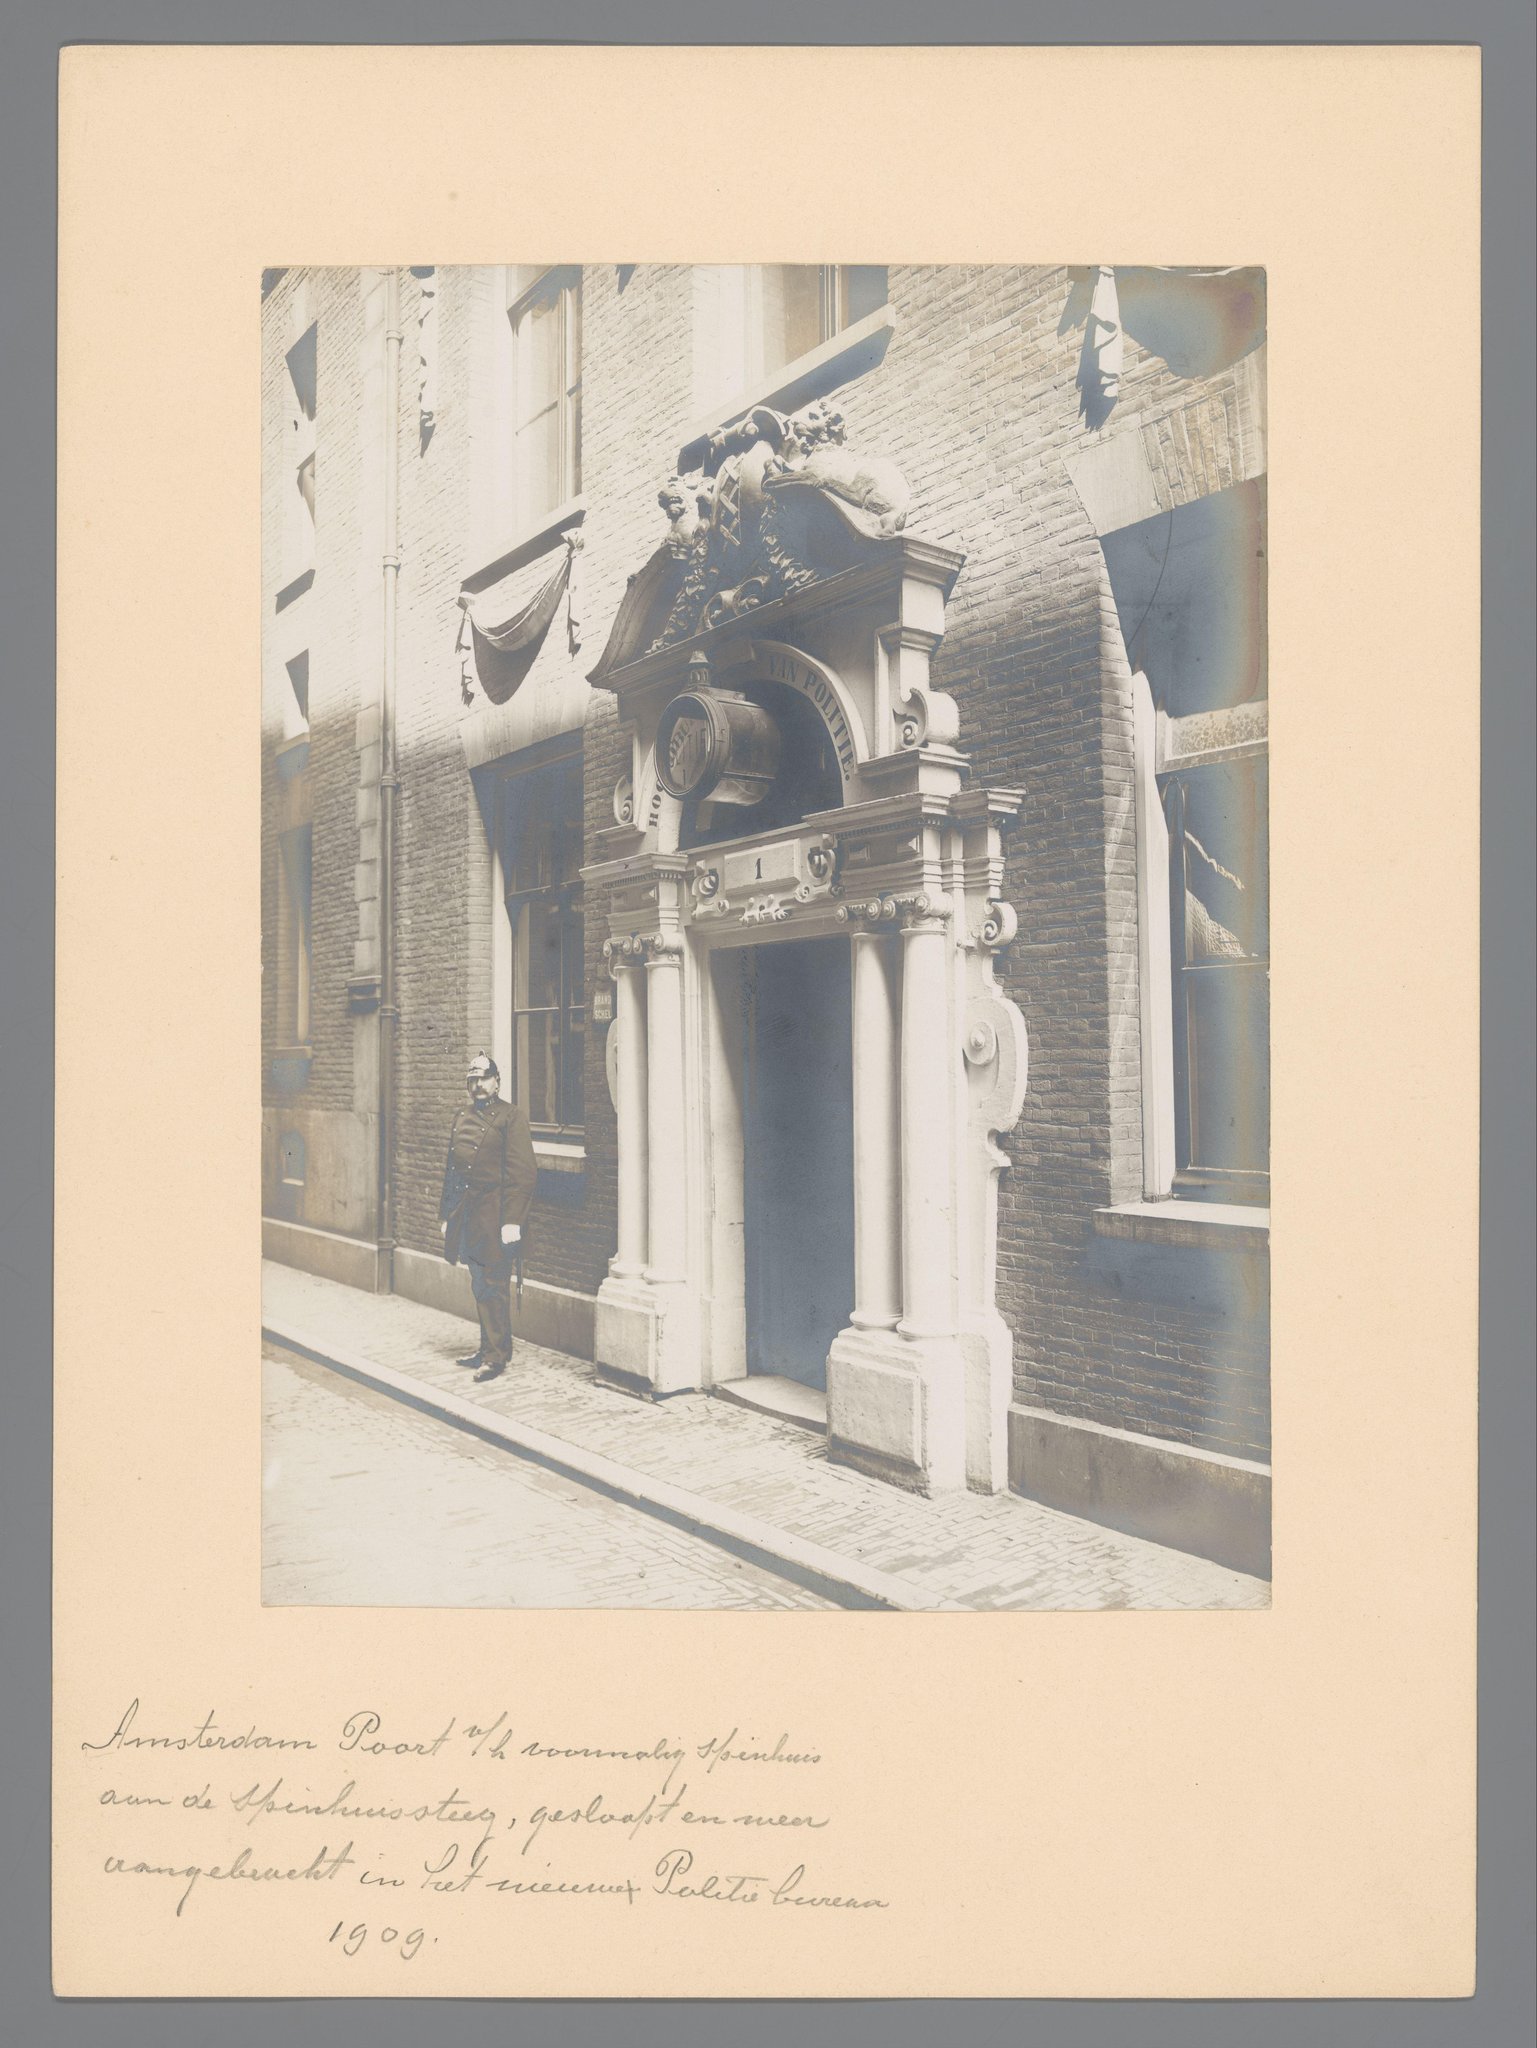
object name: photograph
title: Poort van het Spinhuis, nu aangebracht in het nieuwe politiebureau in de Spinhuissteeg te Amsterdam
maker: Anonymous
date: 1909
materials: cardboard, photographic support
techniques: gelatin silver print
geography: amsterdam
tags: policeman, constable, gate, entrance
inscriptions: annotation: ‘Amsterdam Poort v/h voormalig Spinhuis/ aan de Spinhuissteeg, gesloopt en weer/ aangebracht in het nieuwe Politiebureau/ 1909’, name: ‘N. van Ruijven’